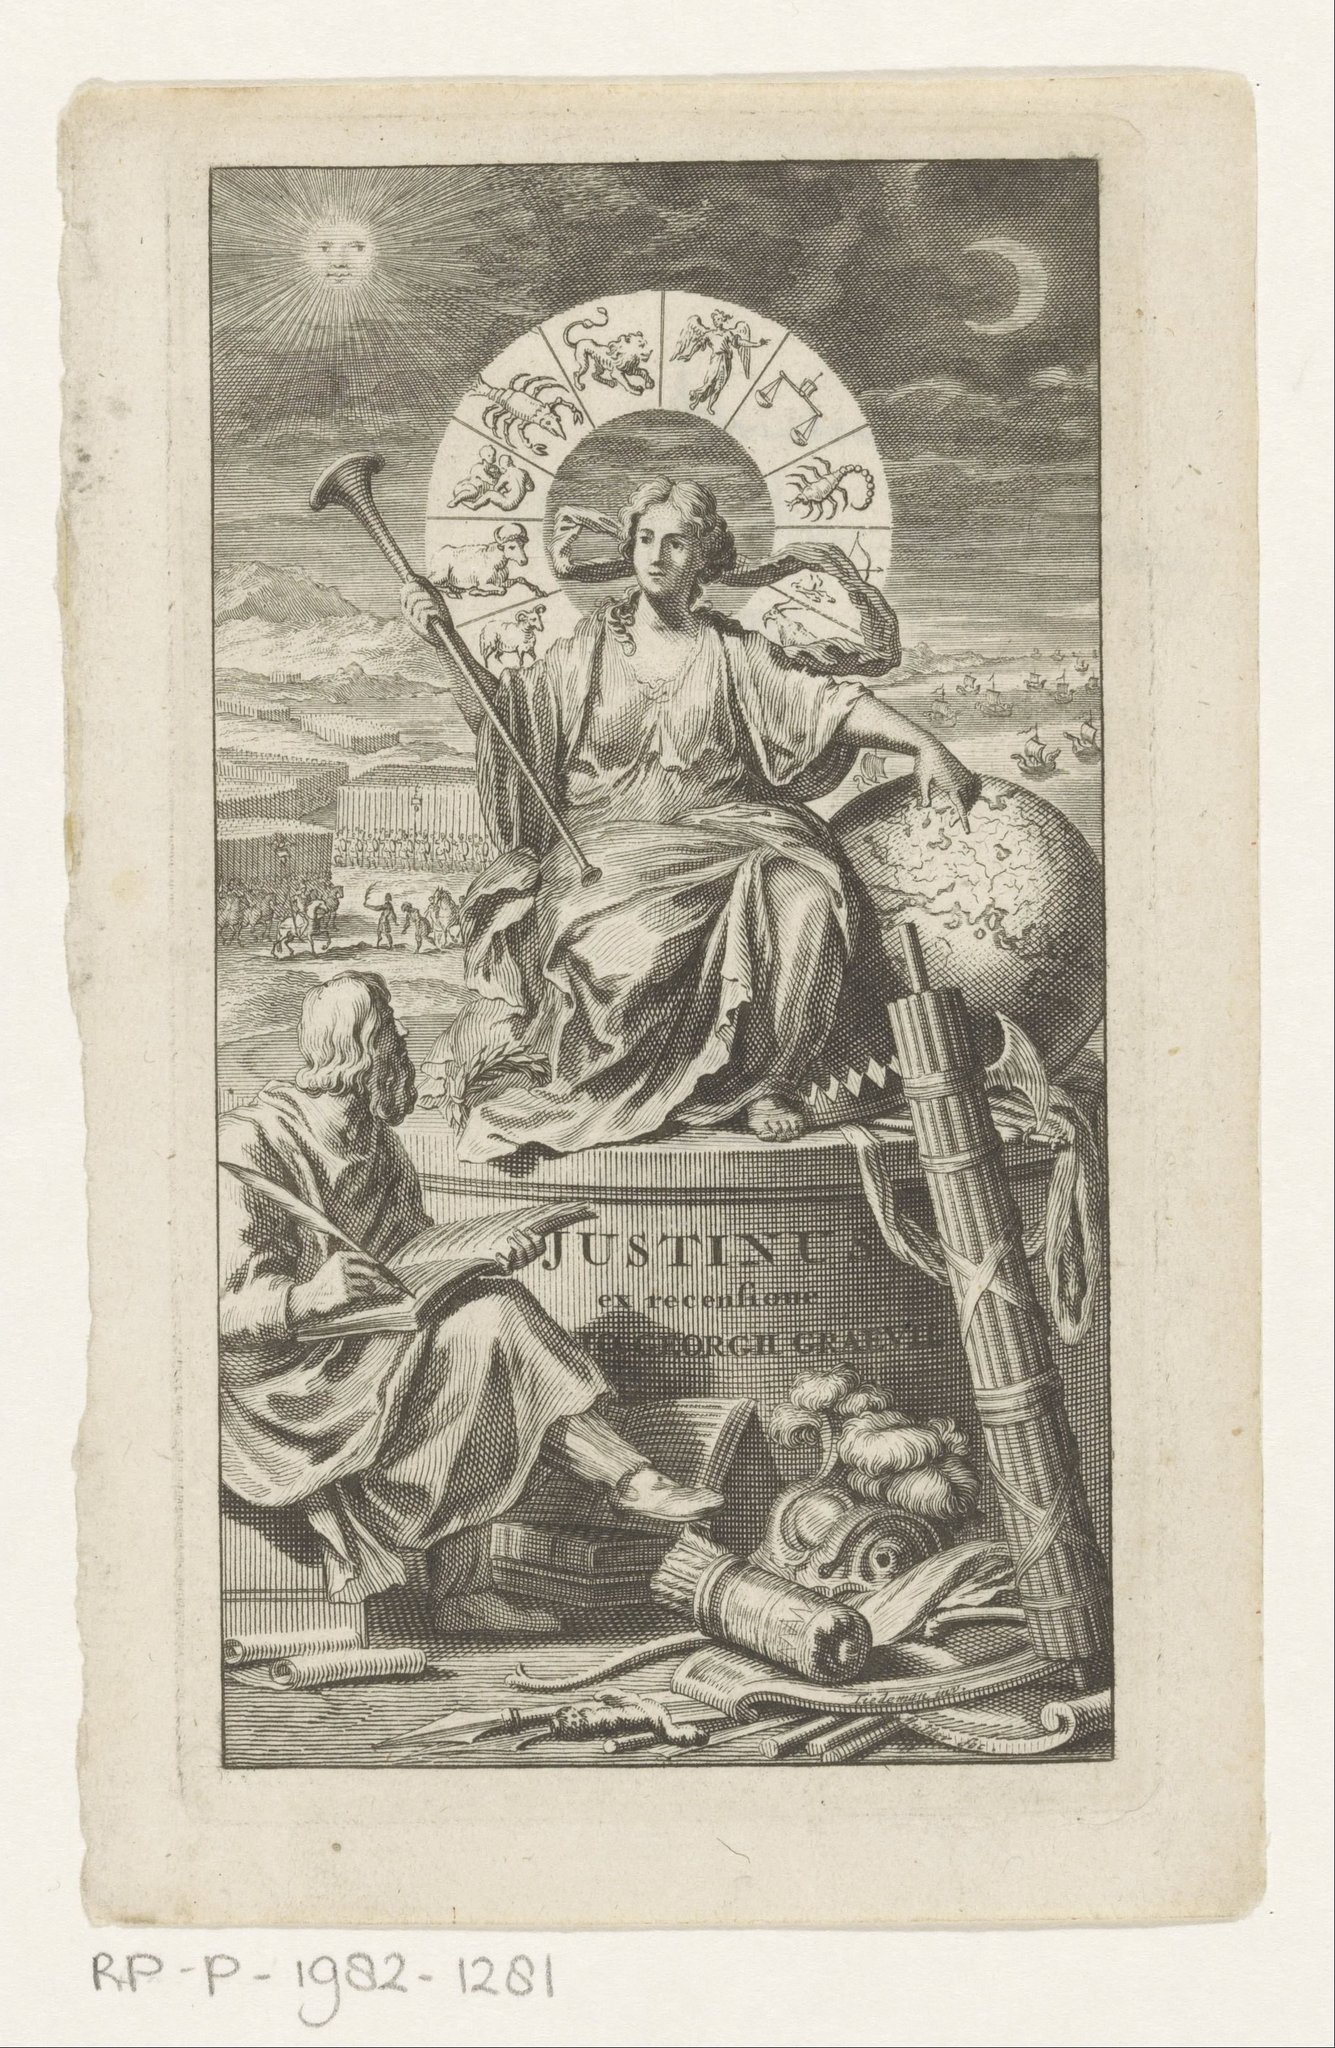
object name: print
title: Allegorische figuur met globe en tekens dierenriem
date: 1694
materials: paper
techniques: engraving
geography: utrecht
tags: day and night, zodiac; the twelve zodiacal signs together, globe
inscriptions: collector's mark: Lugt 2228, collector's mark: Lugt 2760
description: Een vrouw met globe en bazuin gezeten op een voetstuk met de titel van het boek. Achter haar een schijf met de tekens van de dierenriem en in de lucht de zon en de maan. Voor haar zit een in een boek schrijvende man en liggen wapens.